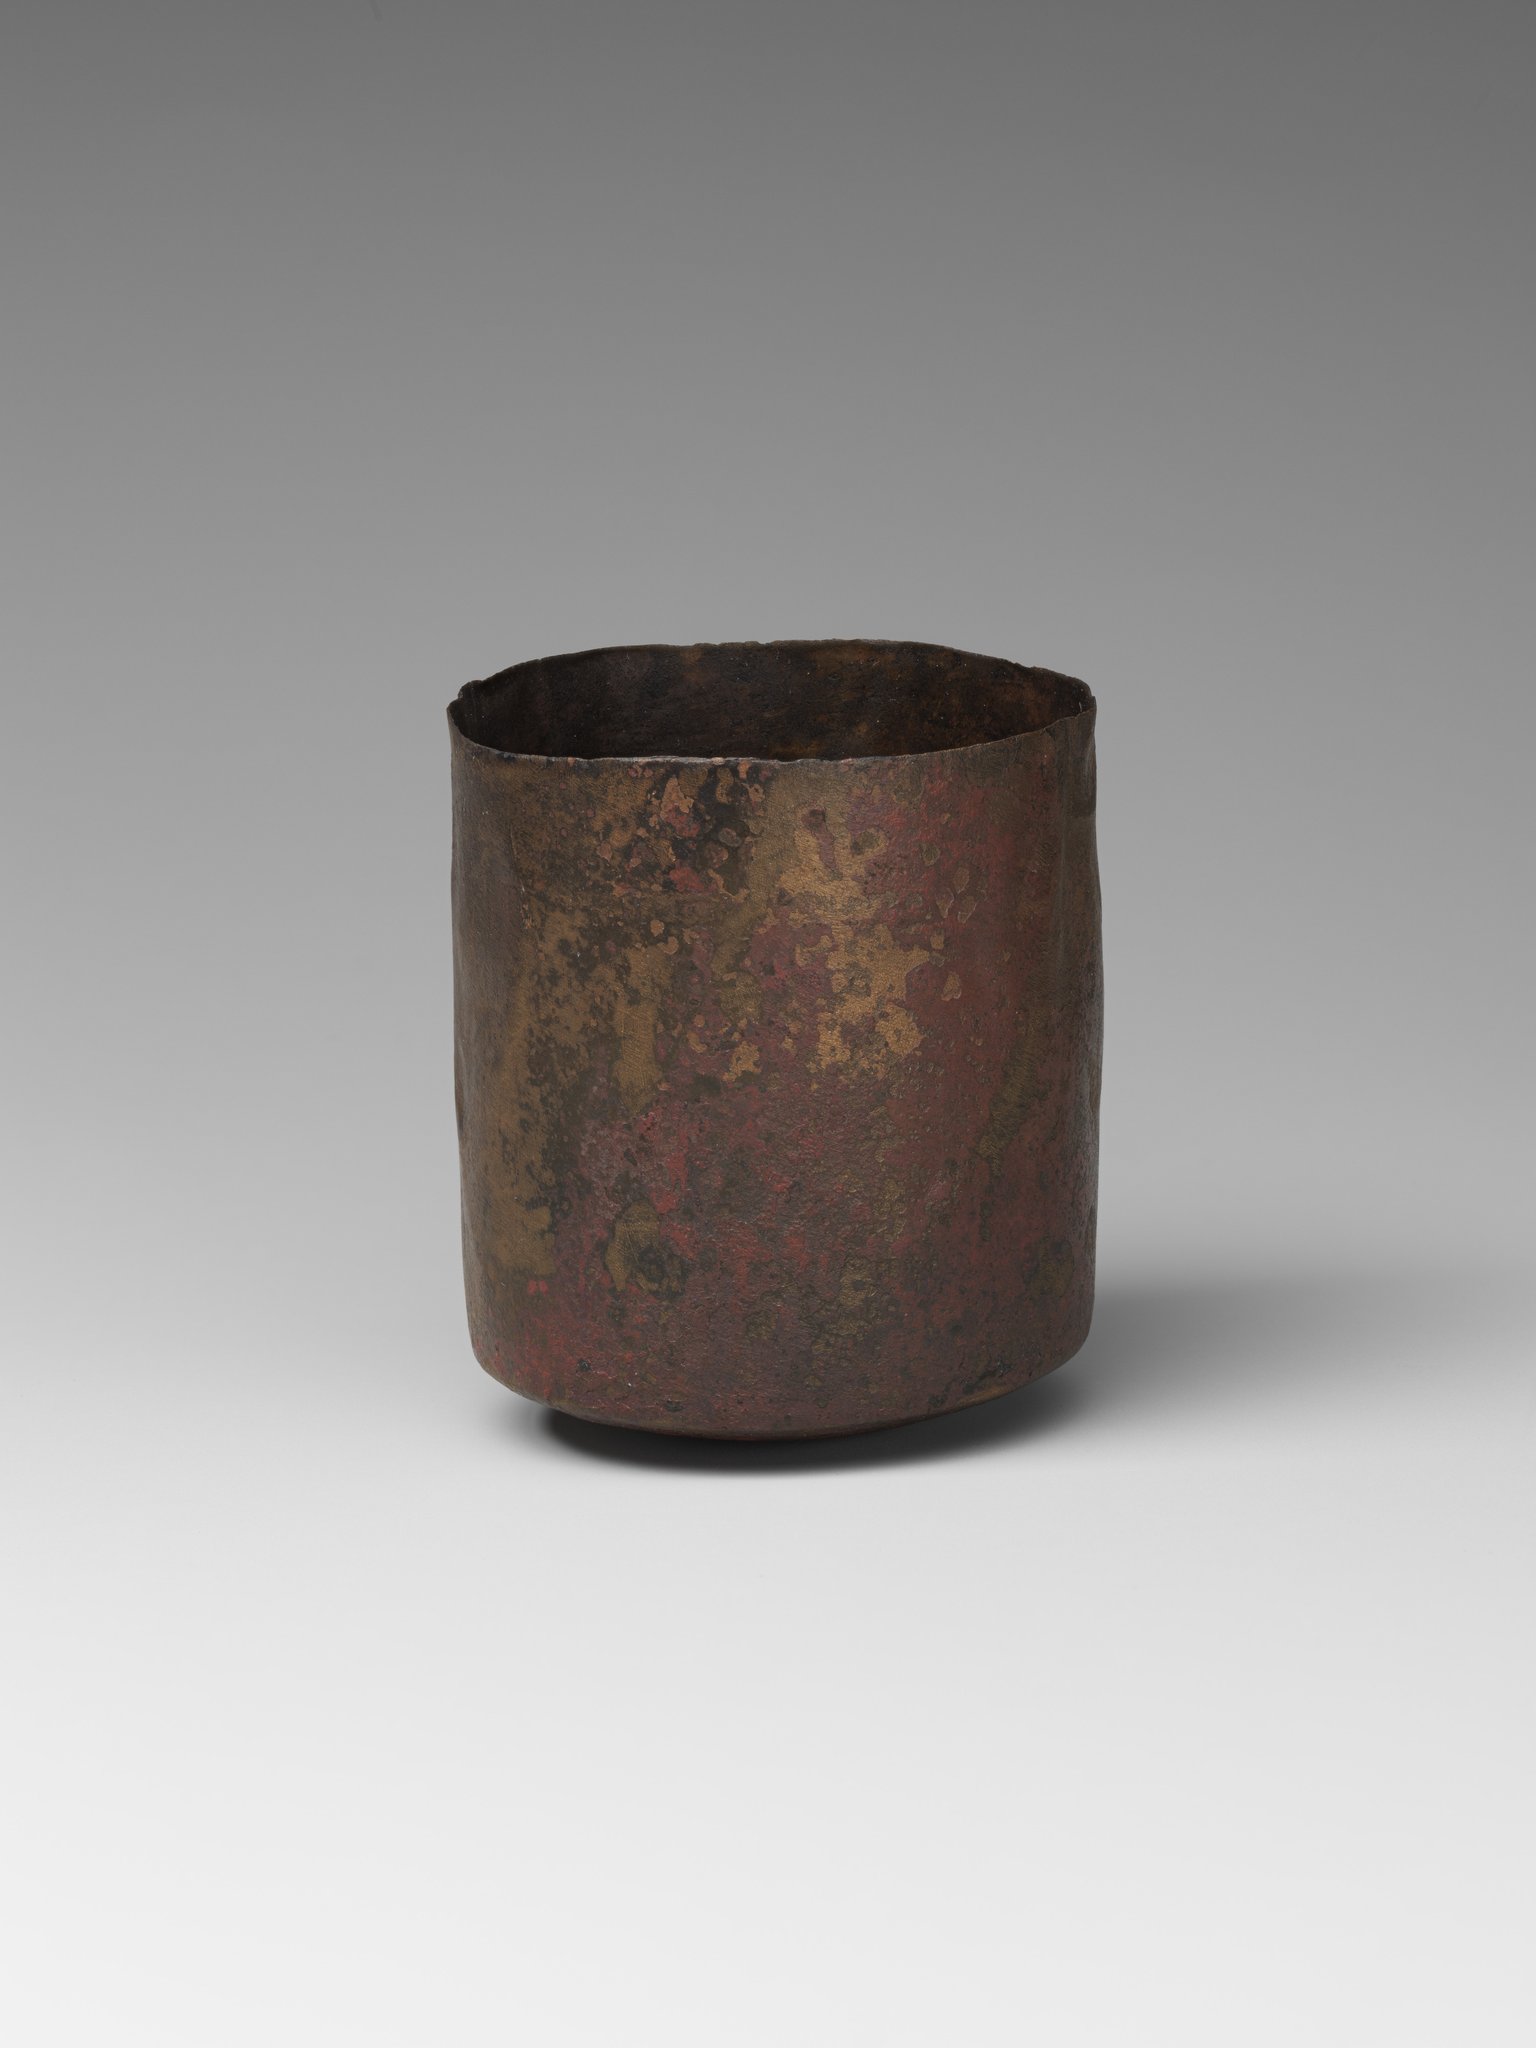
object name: cup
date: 664-332 BCE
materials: bronze, copper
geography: egypt